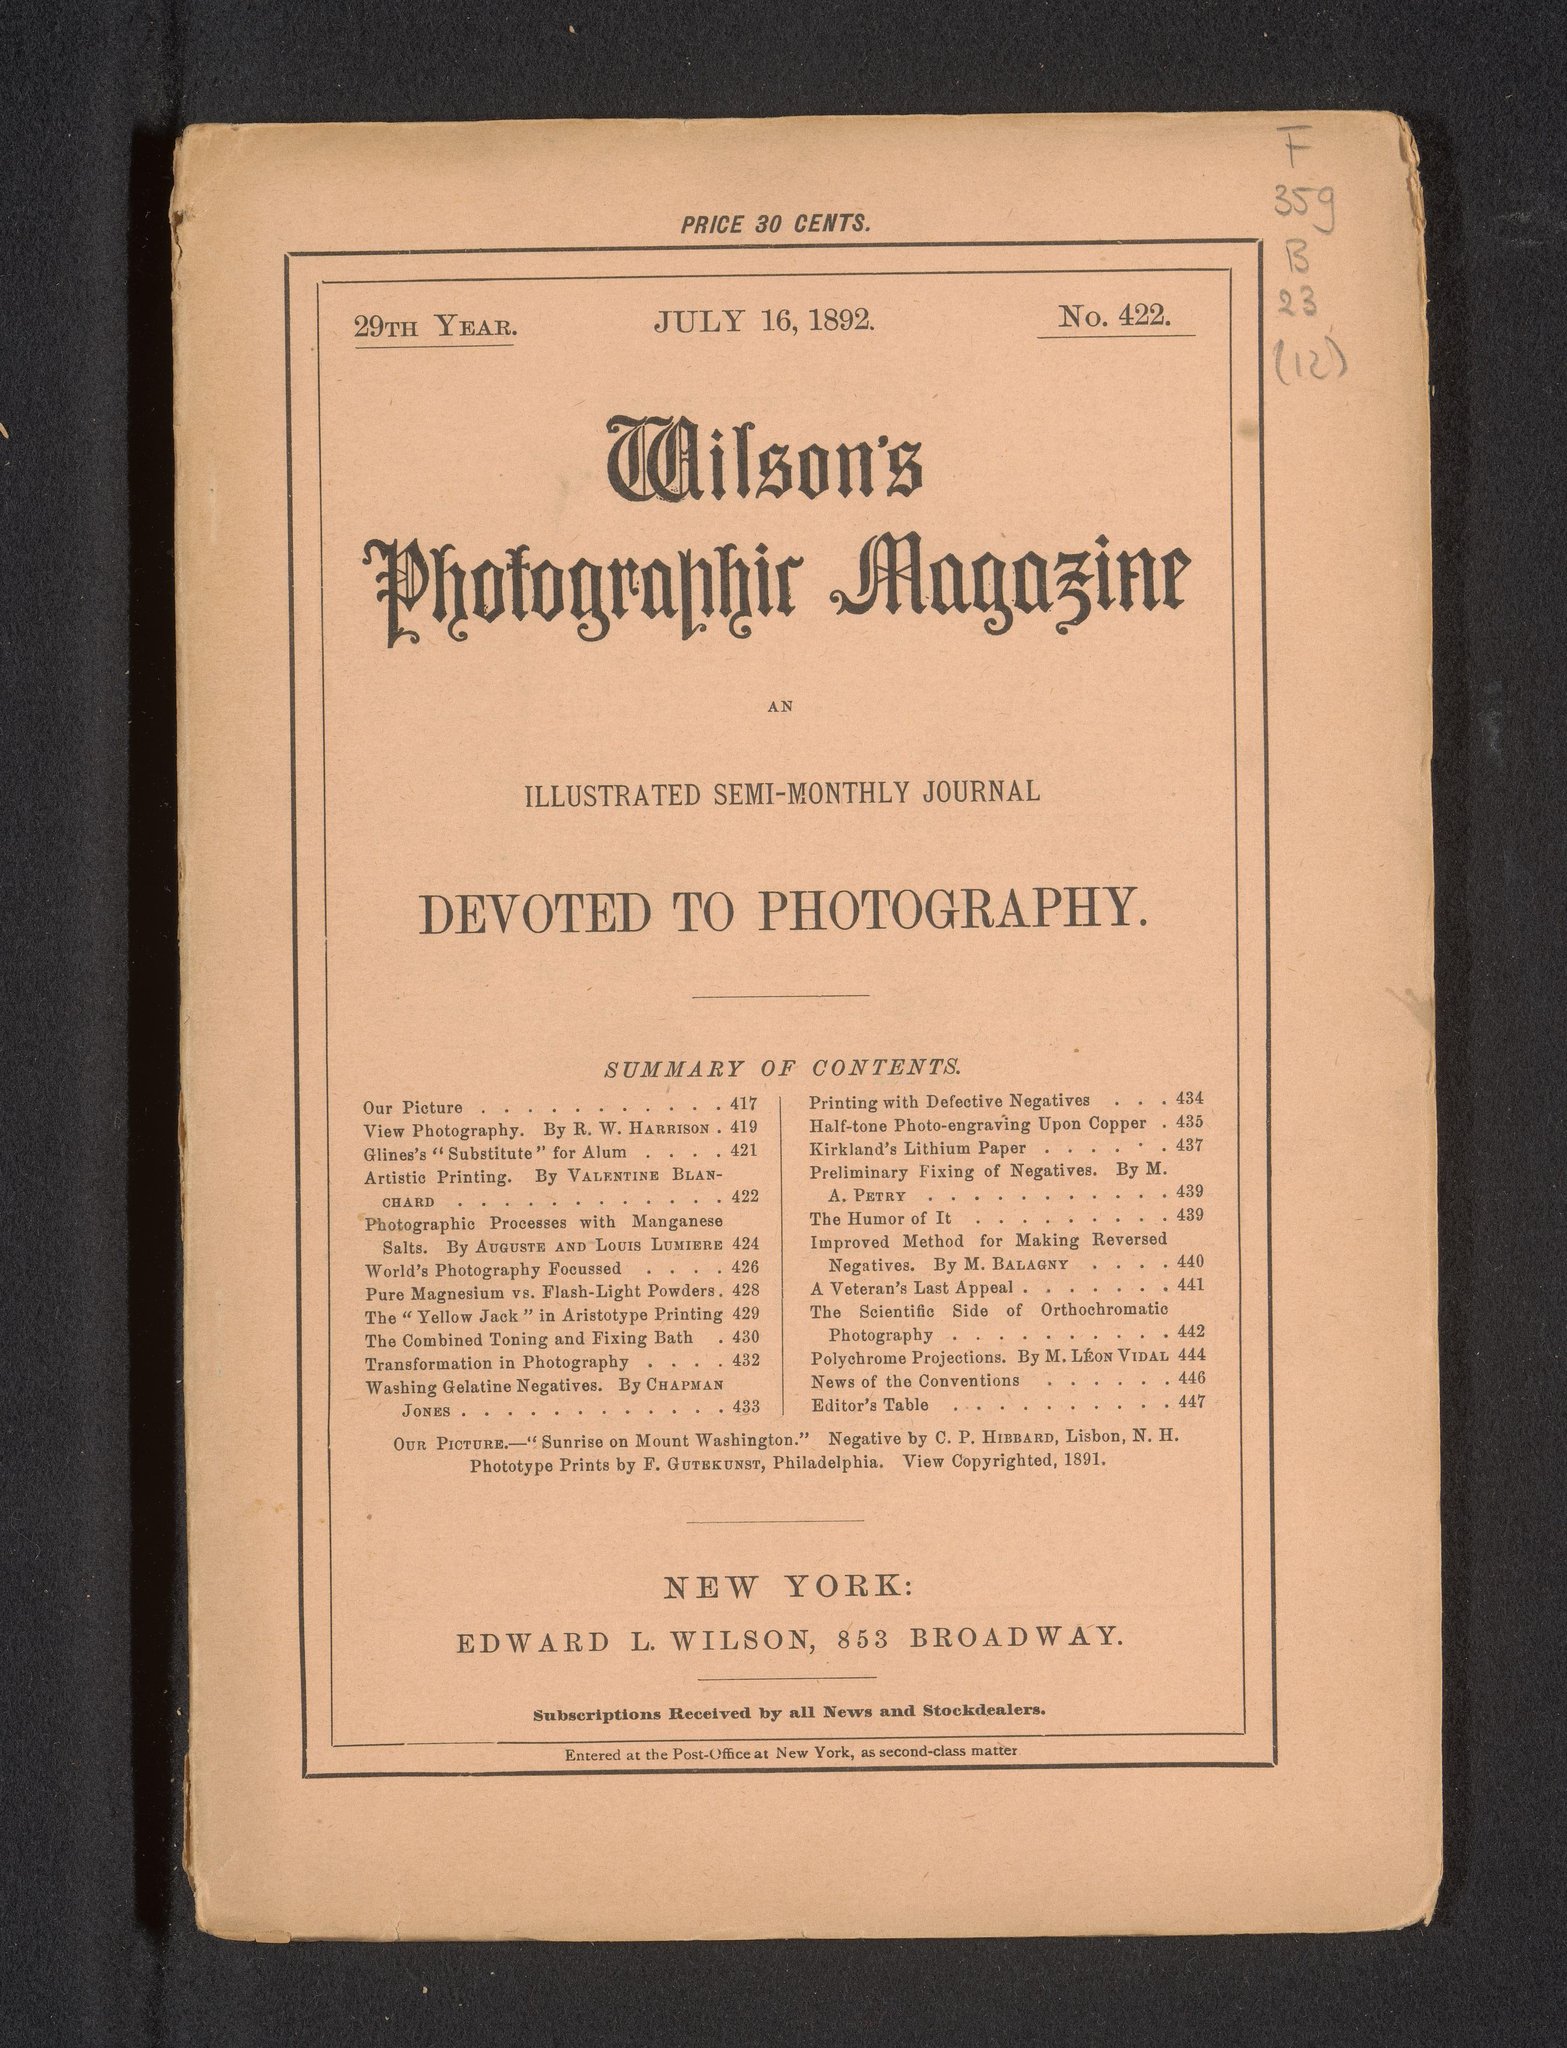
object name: magazine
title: Wilson's photographic magazine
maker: edward livingston wilson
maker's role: publisher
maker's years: 1838-1903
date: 1892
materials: paper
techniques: photograph, printing, engraving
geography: new york city